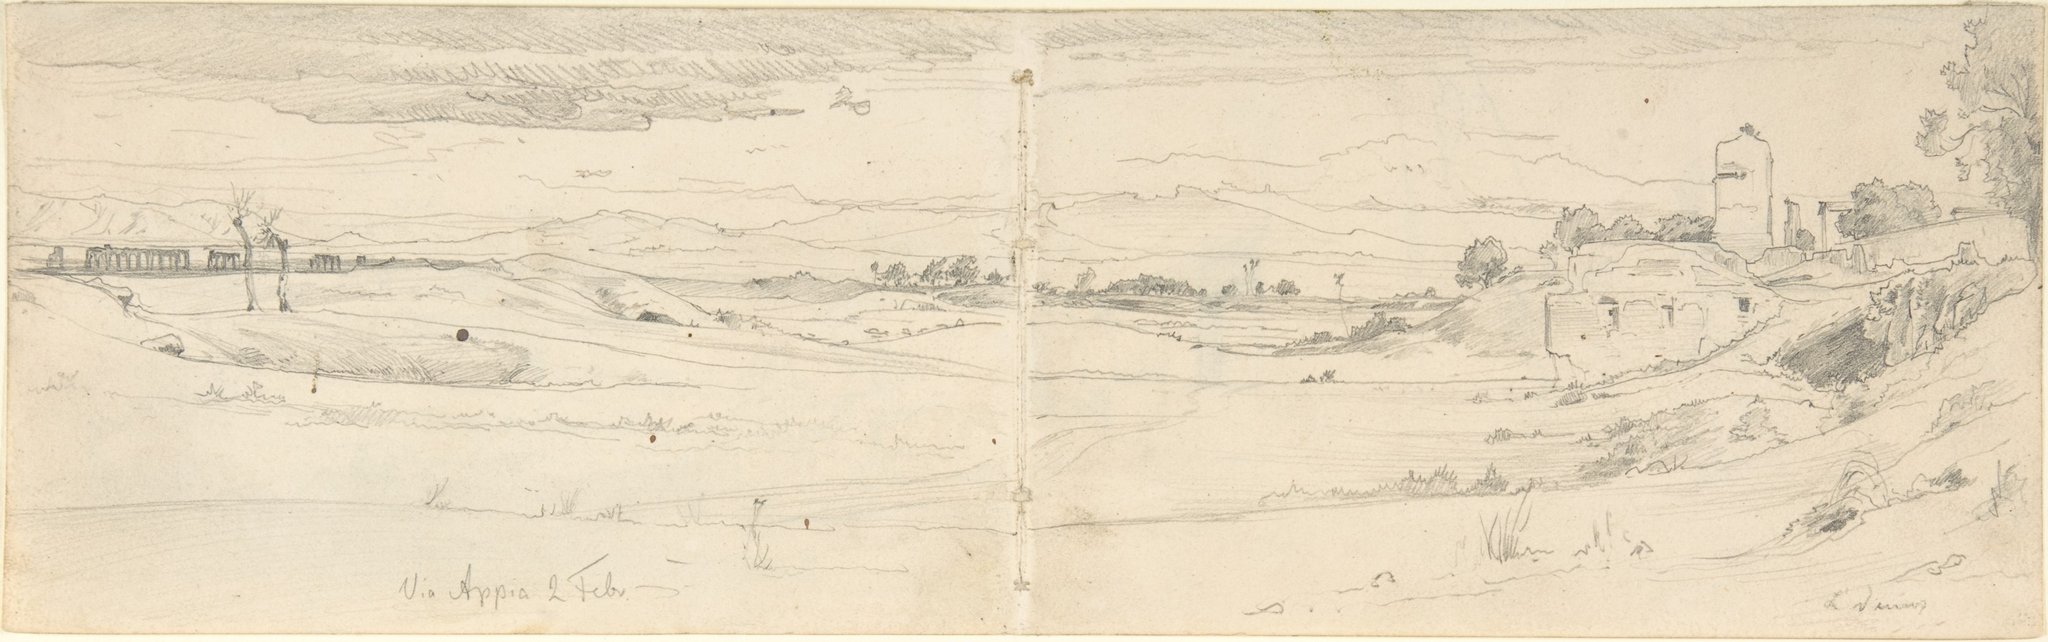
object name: drawing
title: View of the Appian Way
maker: august leopold venus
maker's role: artist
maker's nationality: german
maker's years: 1843-1886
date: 1866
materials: graphite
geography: germany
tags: landscapes